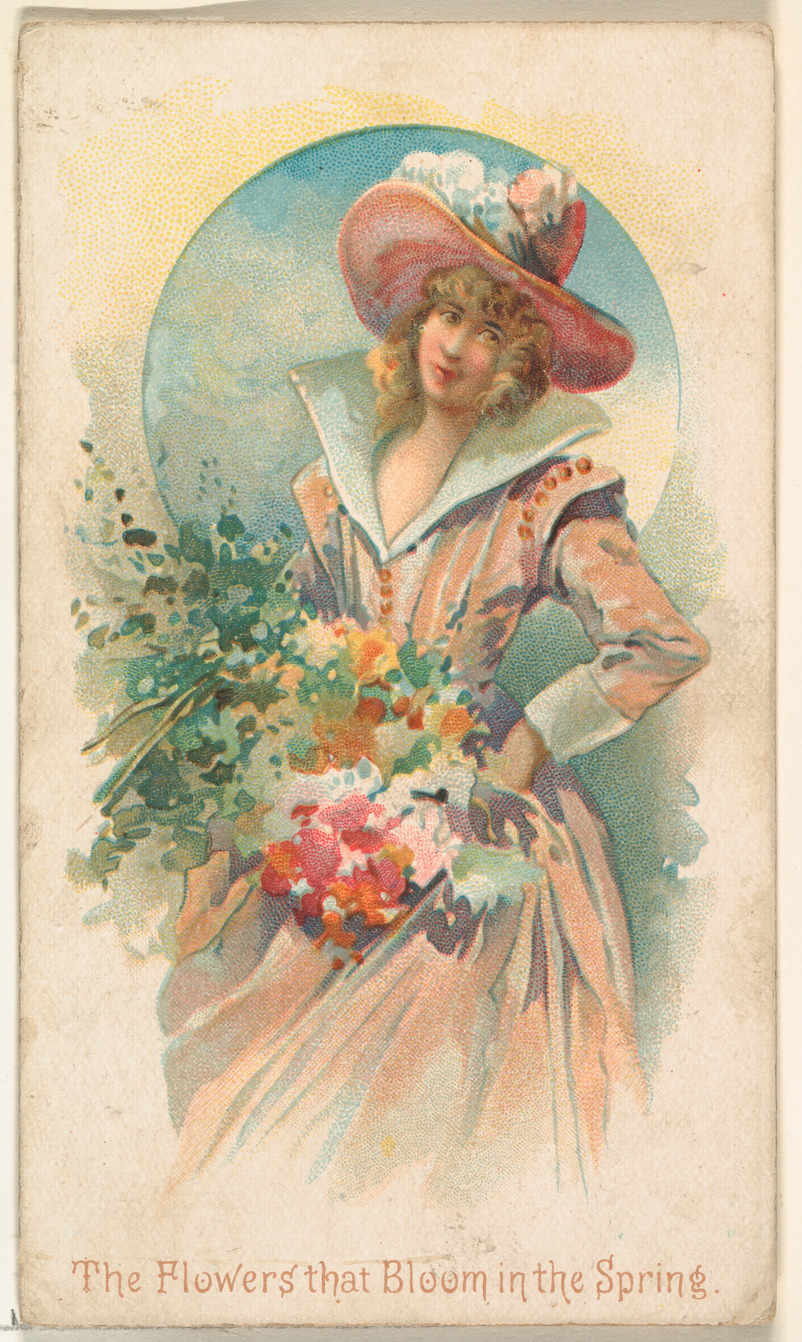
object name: print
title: The Flowers that Bloom in the Spring, from the Illustrated Songs series (N116) issued by W. Duke, Sons & Co. to promote Honest Long Cut Tobacco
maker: w. duke, sons & co.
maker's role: publisher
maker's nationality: american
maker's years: 1870-1920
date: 1893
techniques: color lithograph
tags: women